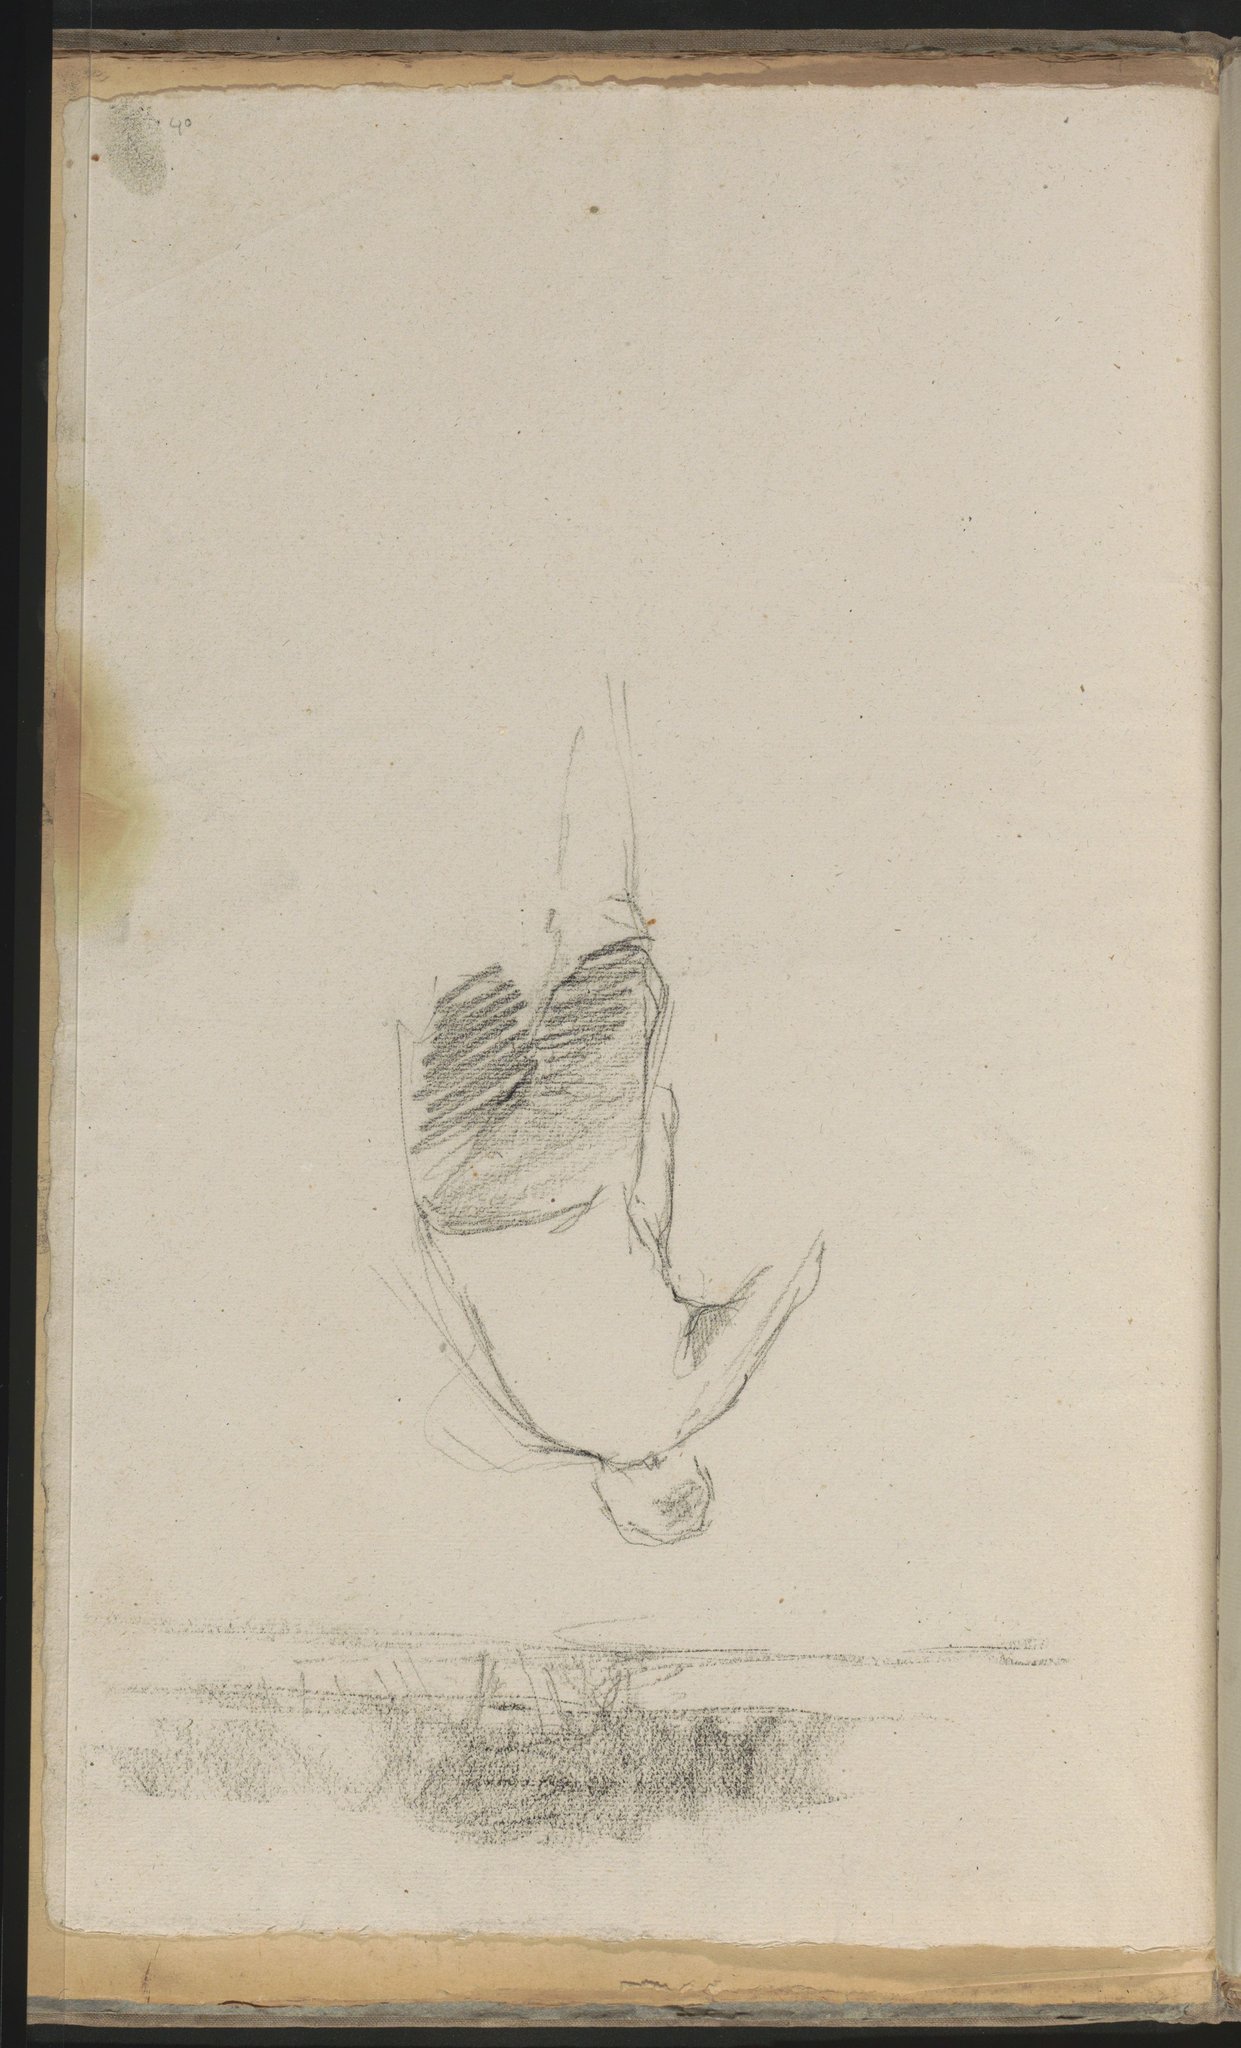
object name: sketchbook leaf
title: Landschap met een voorovergebogen man, op de rug gezien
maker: willem witsen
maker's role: draughtsman, painter, print maker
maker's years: 1860-1923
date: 1884-1887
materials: chalk, paper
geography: ewijkshoeve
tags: landscapes in the temperate zone, farmers, adult man (+ back view)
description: Mogelijk een boer die aan het werk is. Pagina 40 uit een schetsboek met 42 bladen vervaardigd rond de Ewijkshoeve.